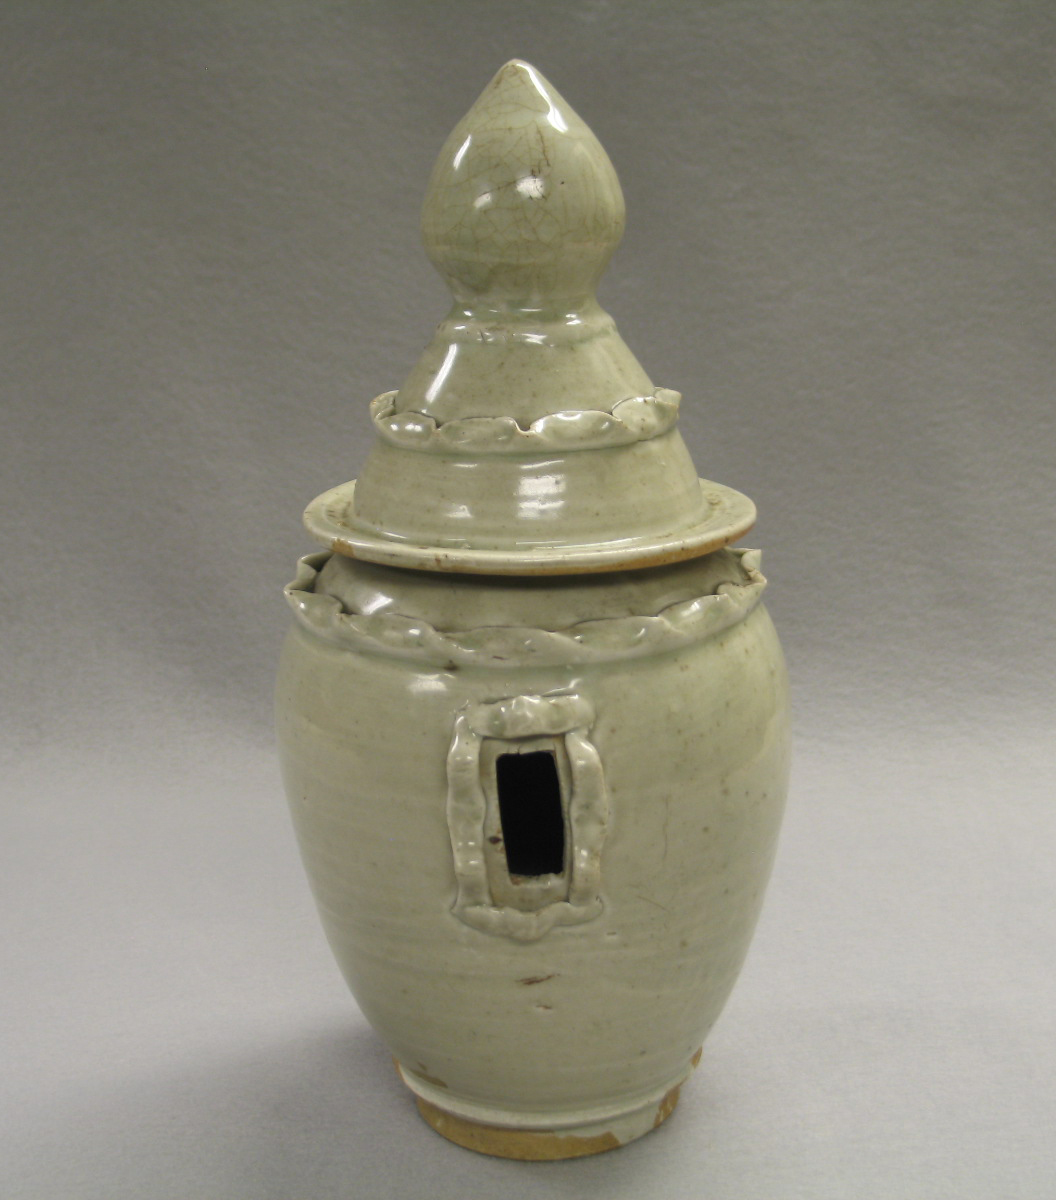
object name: urn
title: Tomb urn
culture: chinese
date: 1001-1200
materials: glaze, porcelain